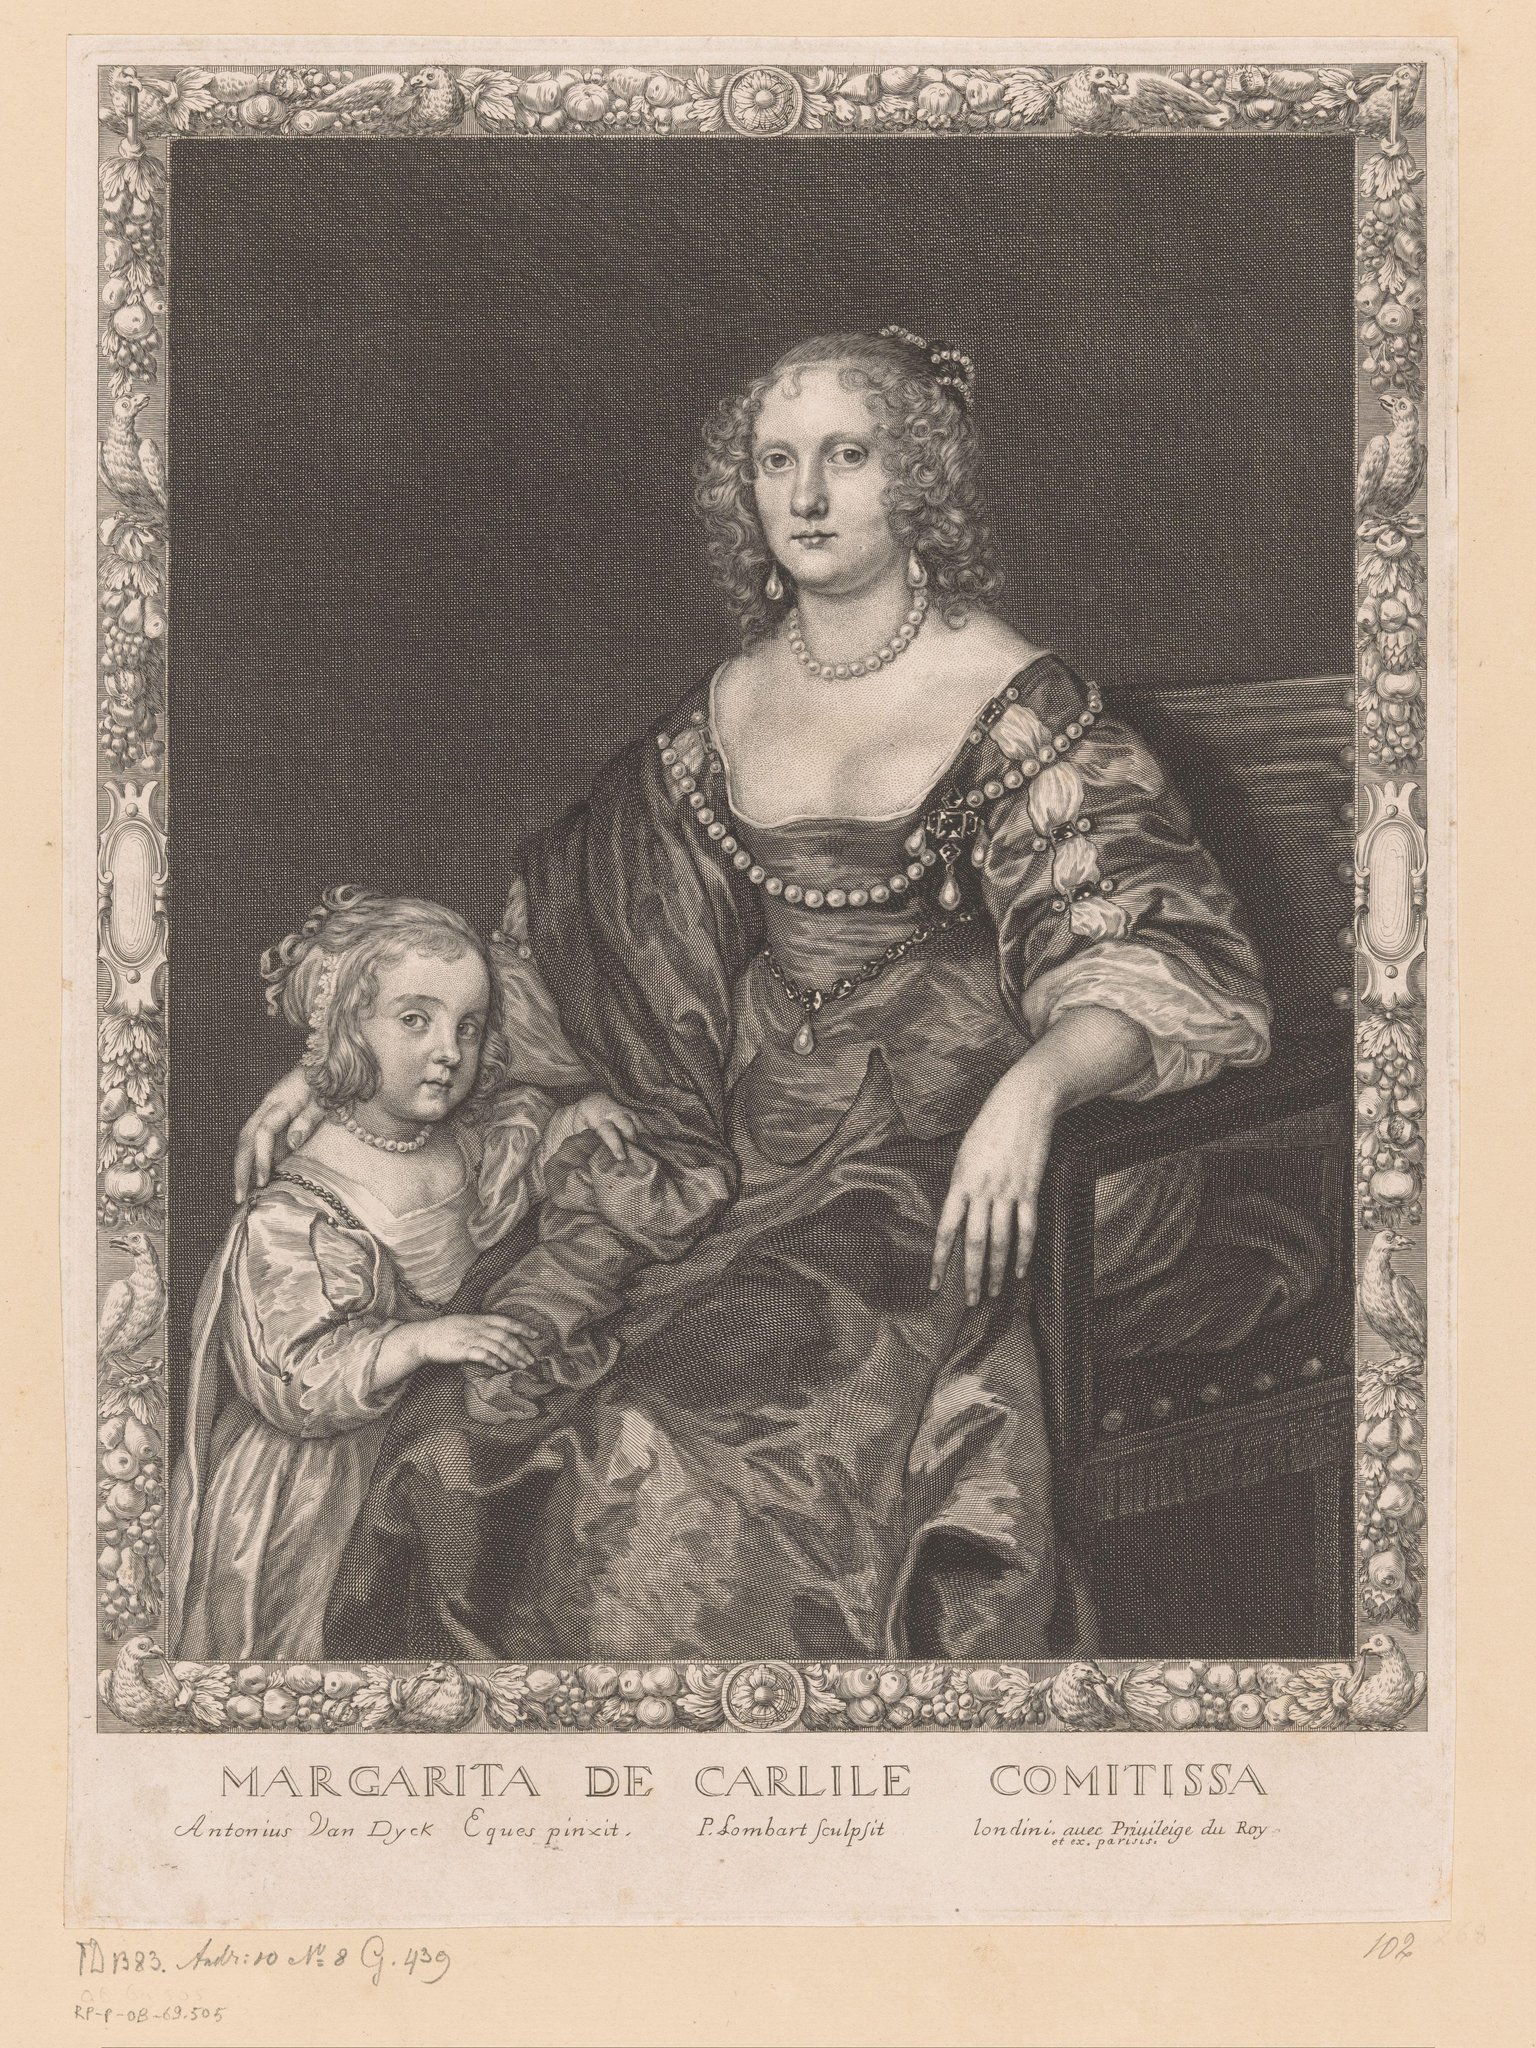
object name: print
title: Margarita de Carlile comitissa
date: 1660-1663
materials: paper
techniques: engraving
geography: london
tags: historical persons - bb - woman, frame of painting, etc., nobility and patriciate; chivalry, knighthood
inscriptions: collector's mark: Lugt 240